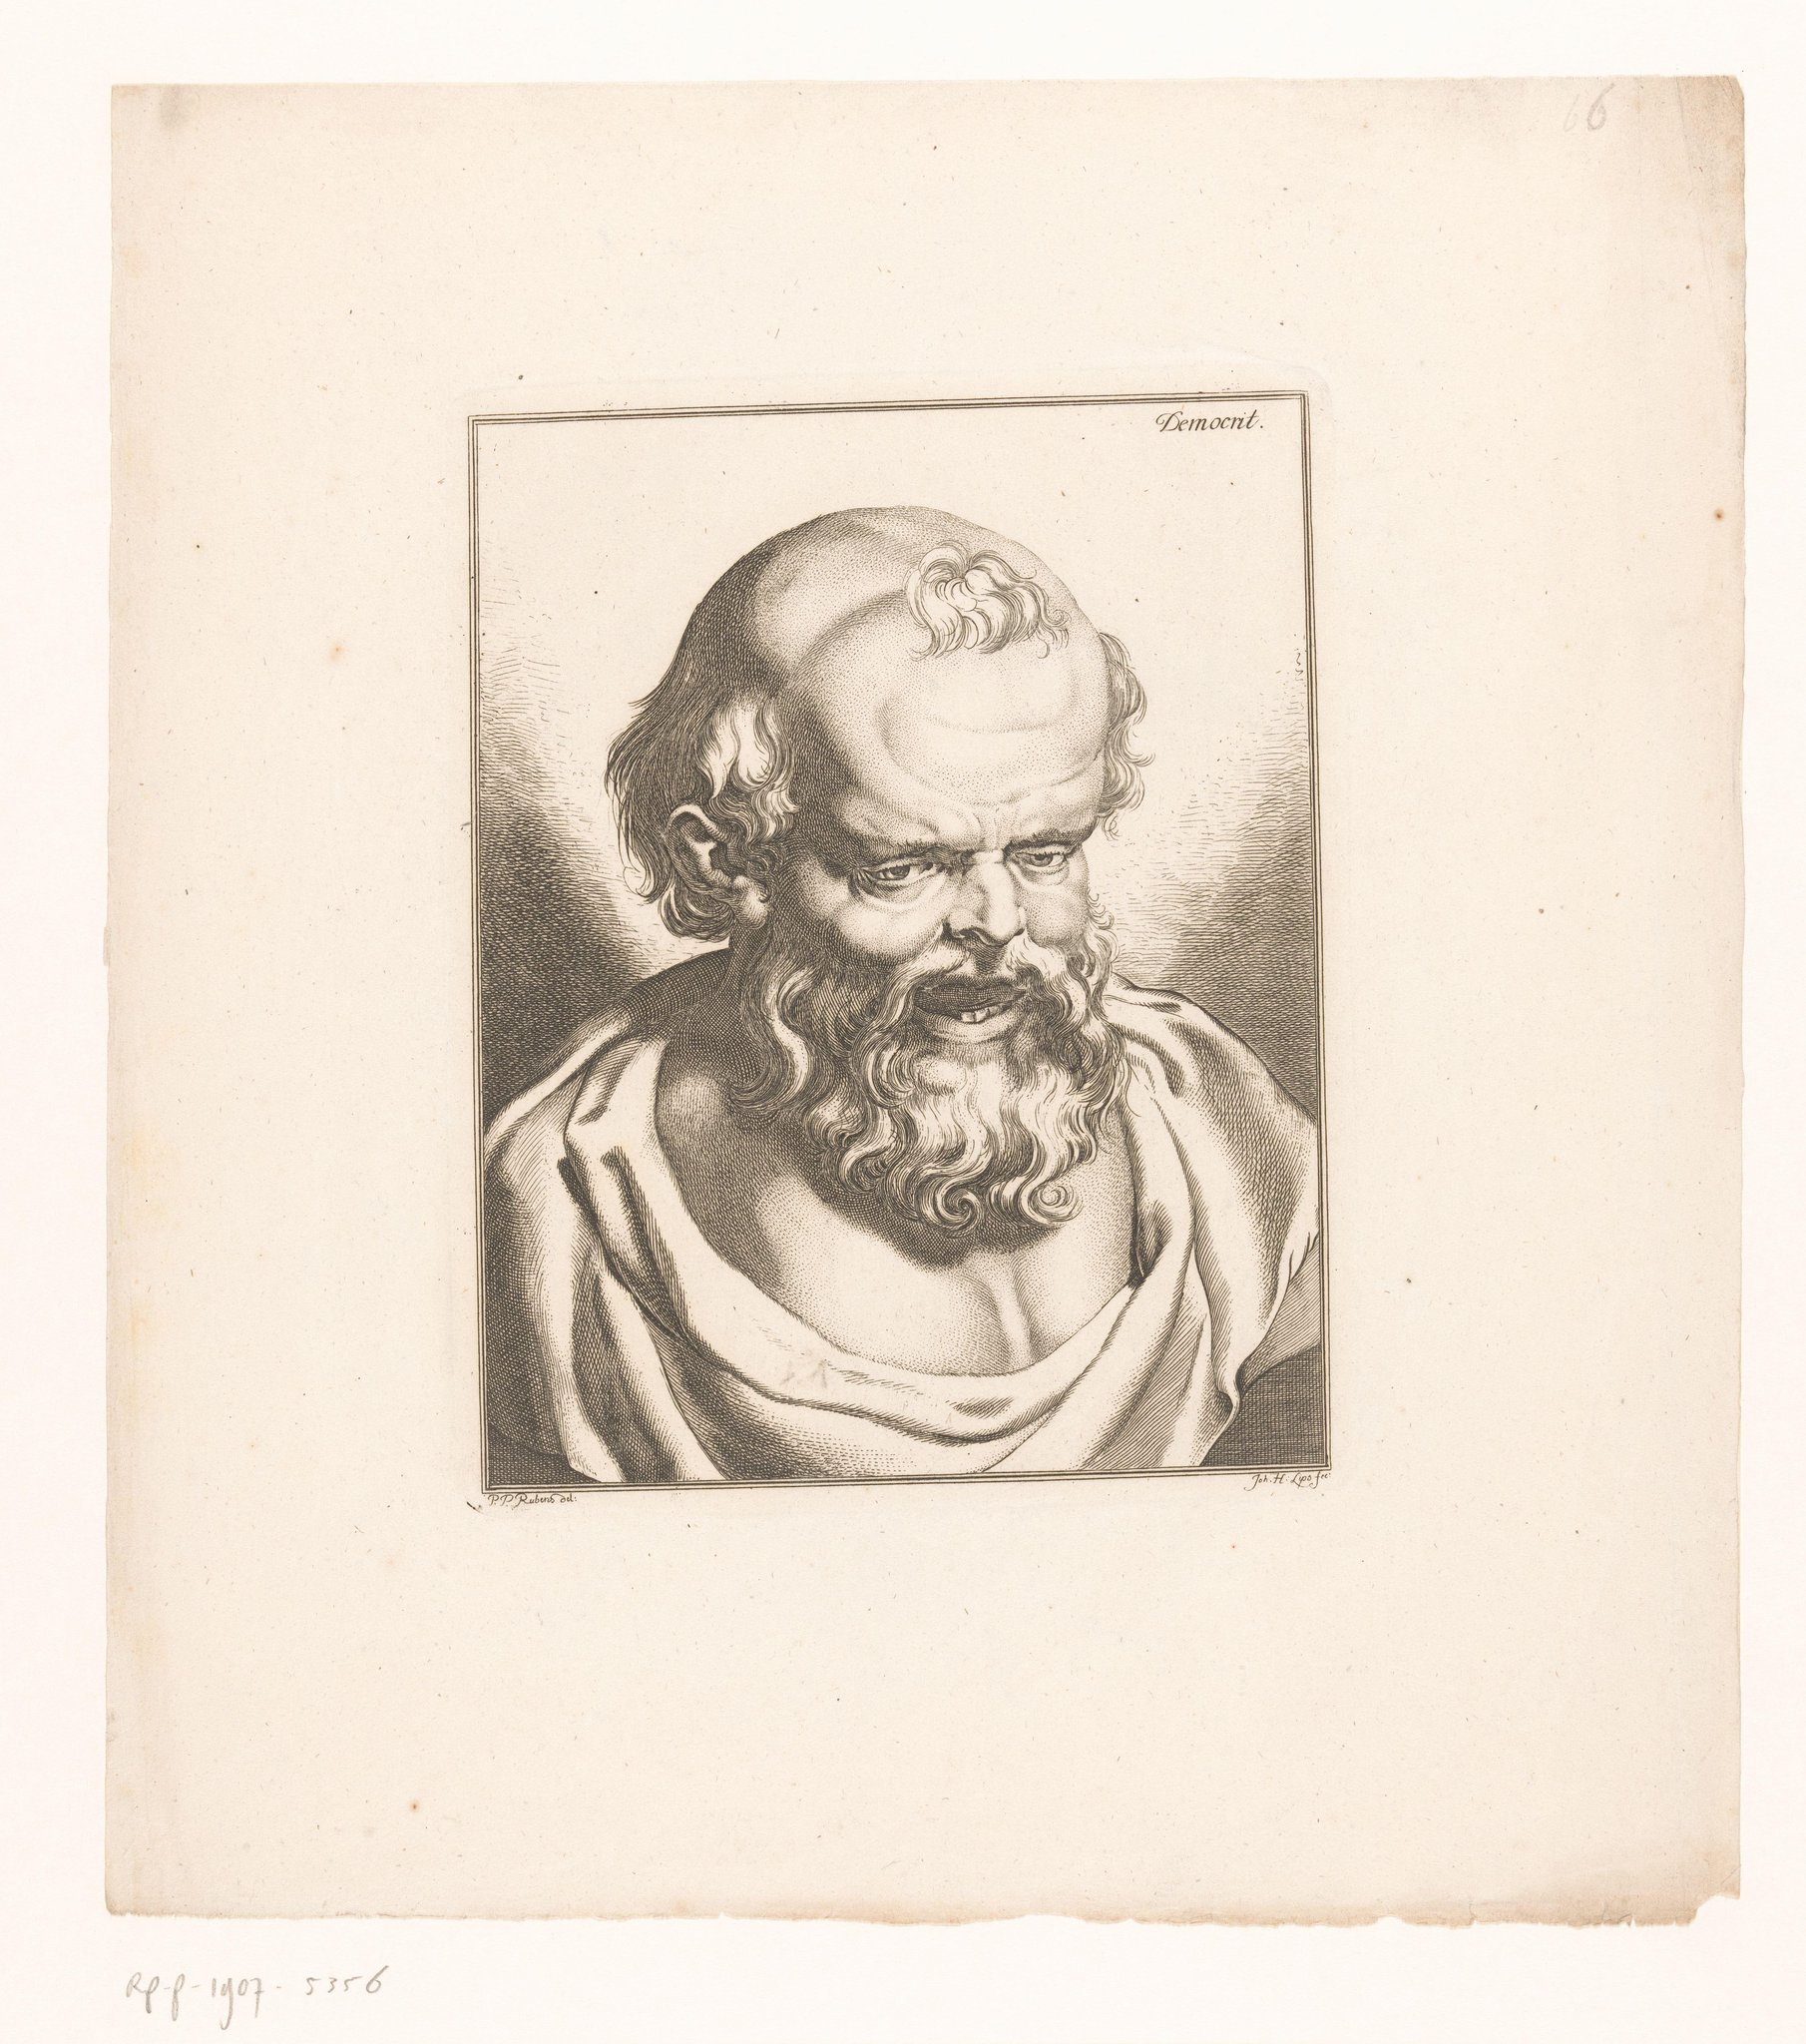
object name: print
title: Portret van Democritus van Abdera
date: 1768-1817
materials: paper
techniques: engraving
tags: traveler, scholar, philosopher, historical persons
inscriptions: collector's mark: Lugt 2228